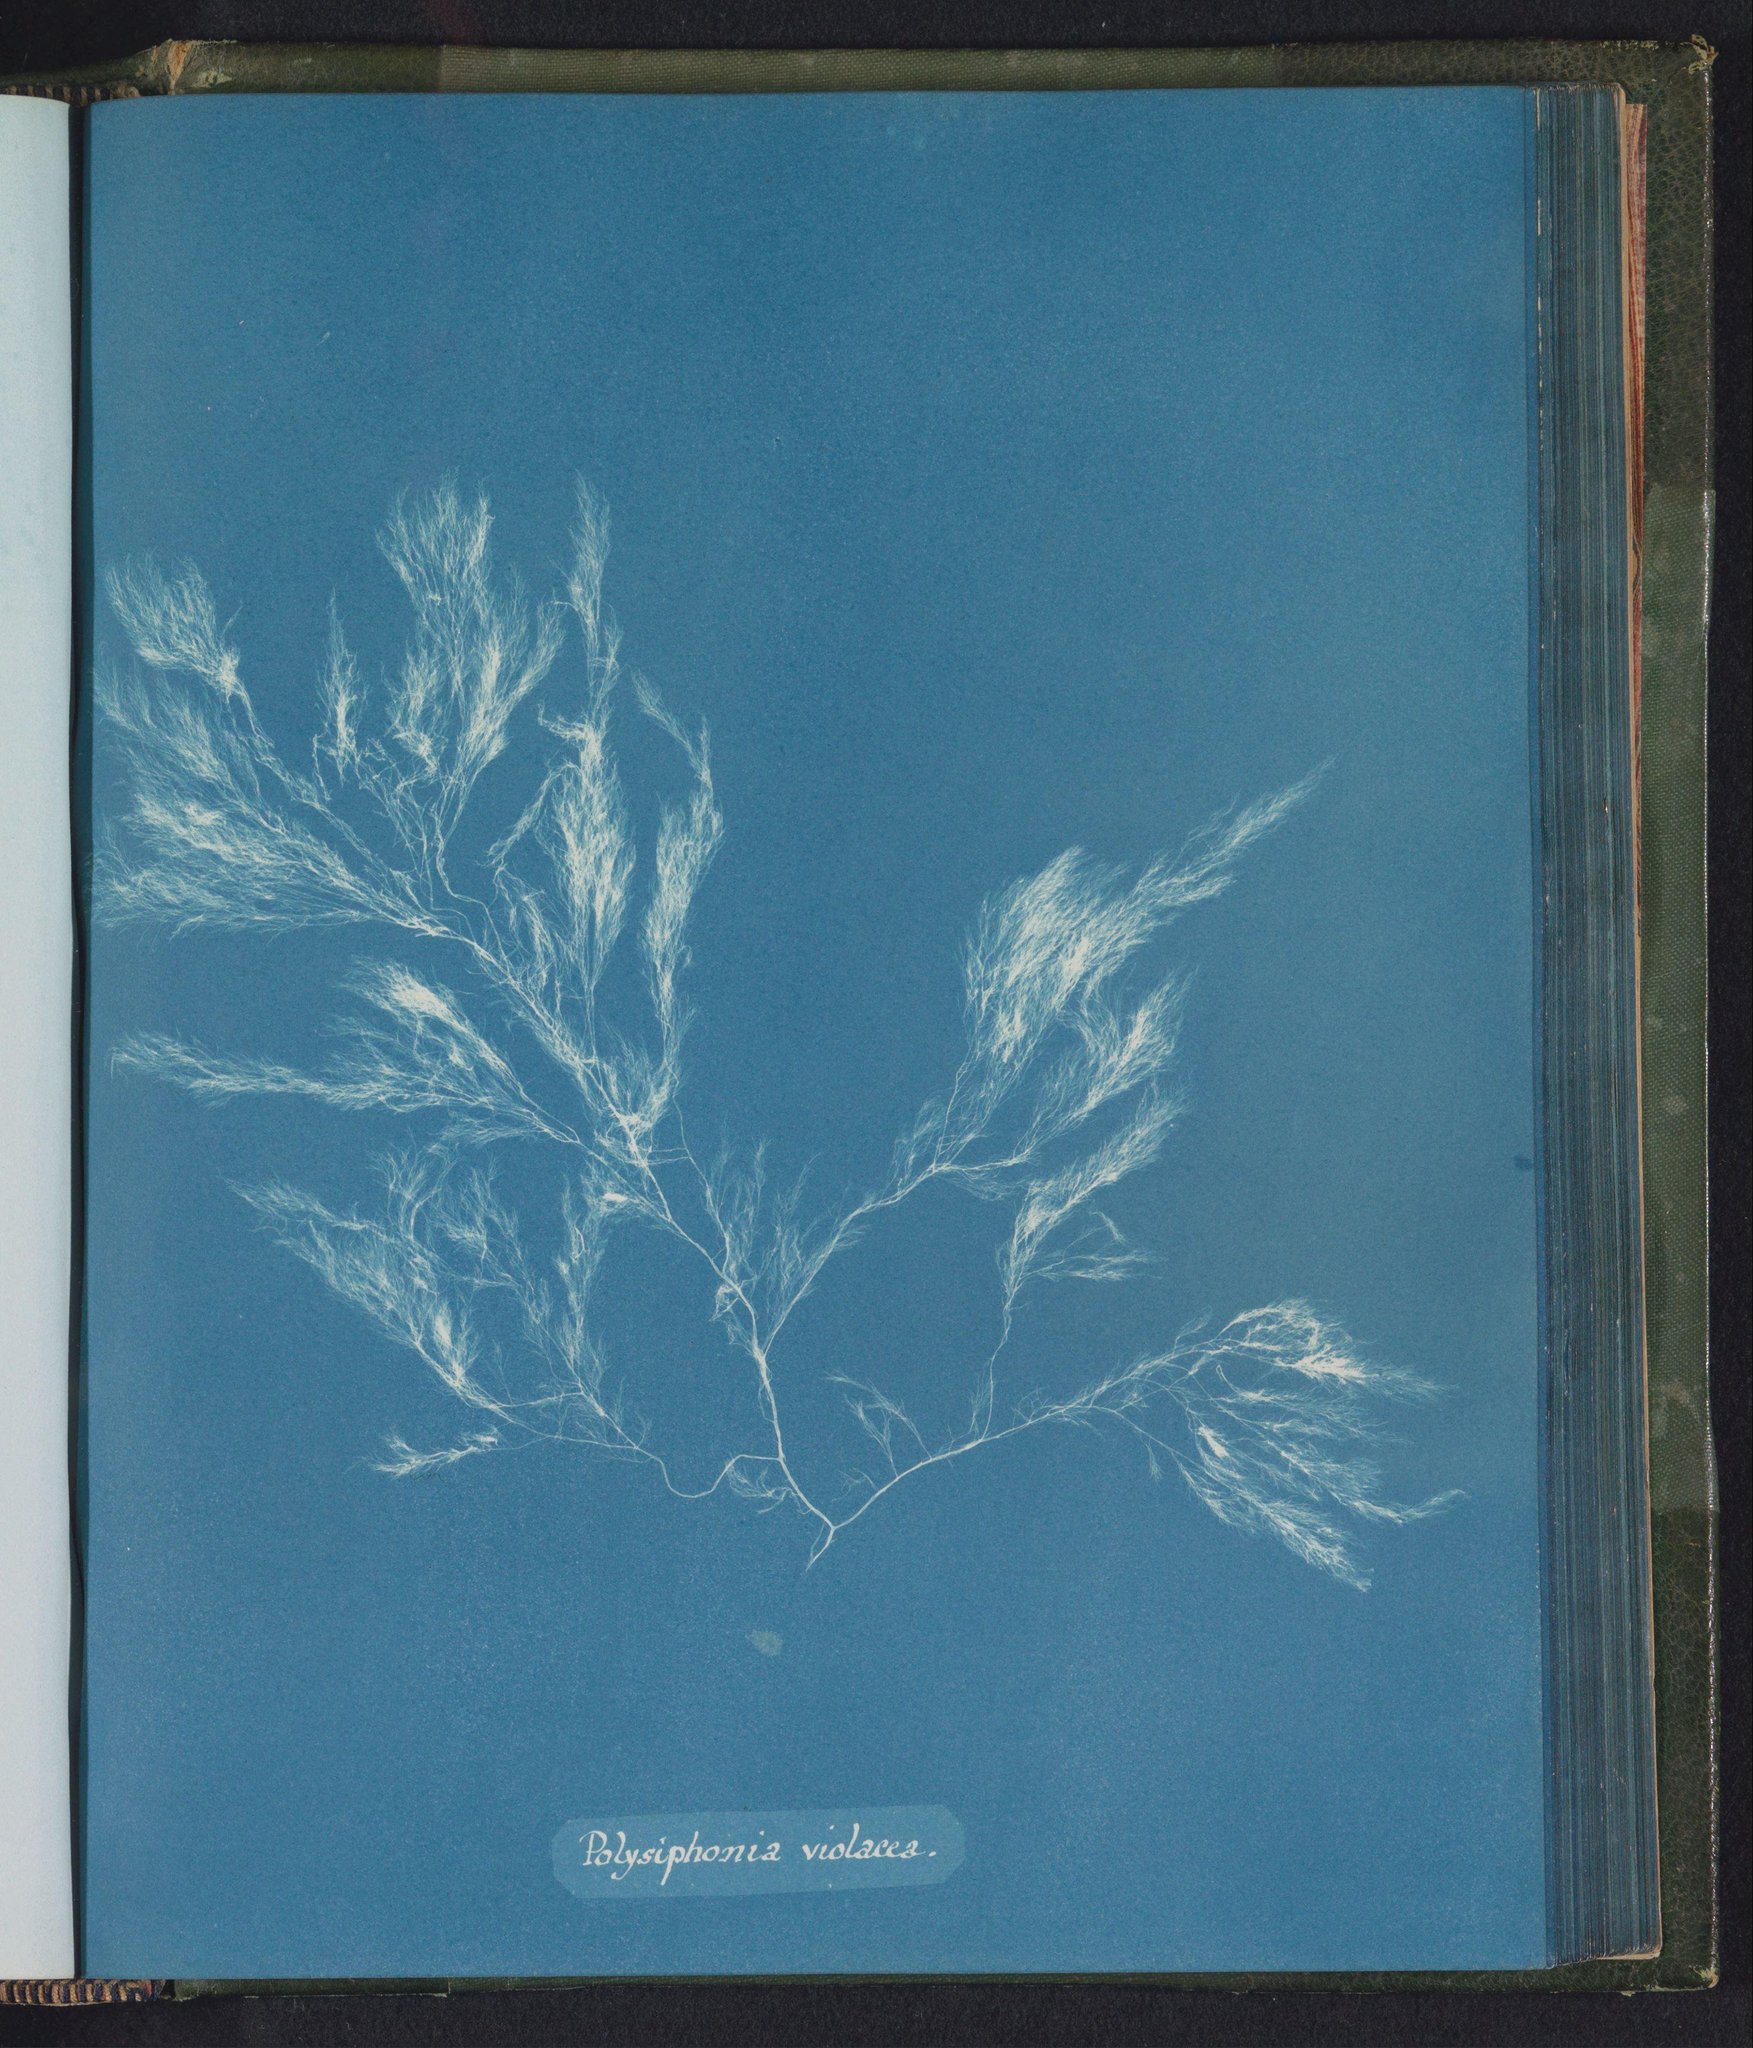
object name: page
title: Polysiphonia violacea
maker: anna atkins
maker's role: fotograaf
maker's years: 1799-1871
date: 1843-1853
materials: photographic support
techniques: cyanotype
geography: united kingdom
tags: algae, seaweed